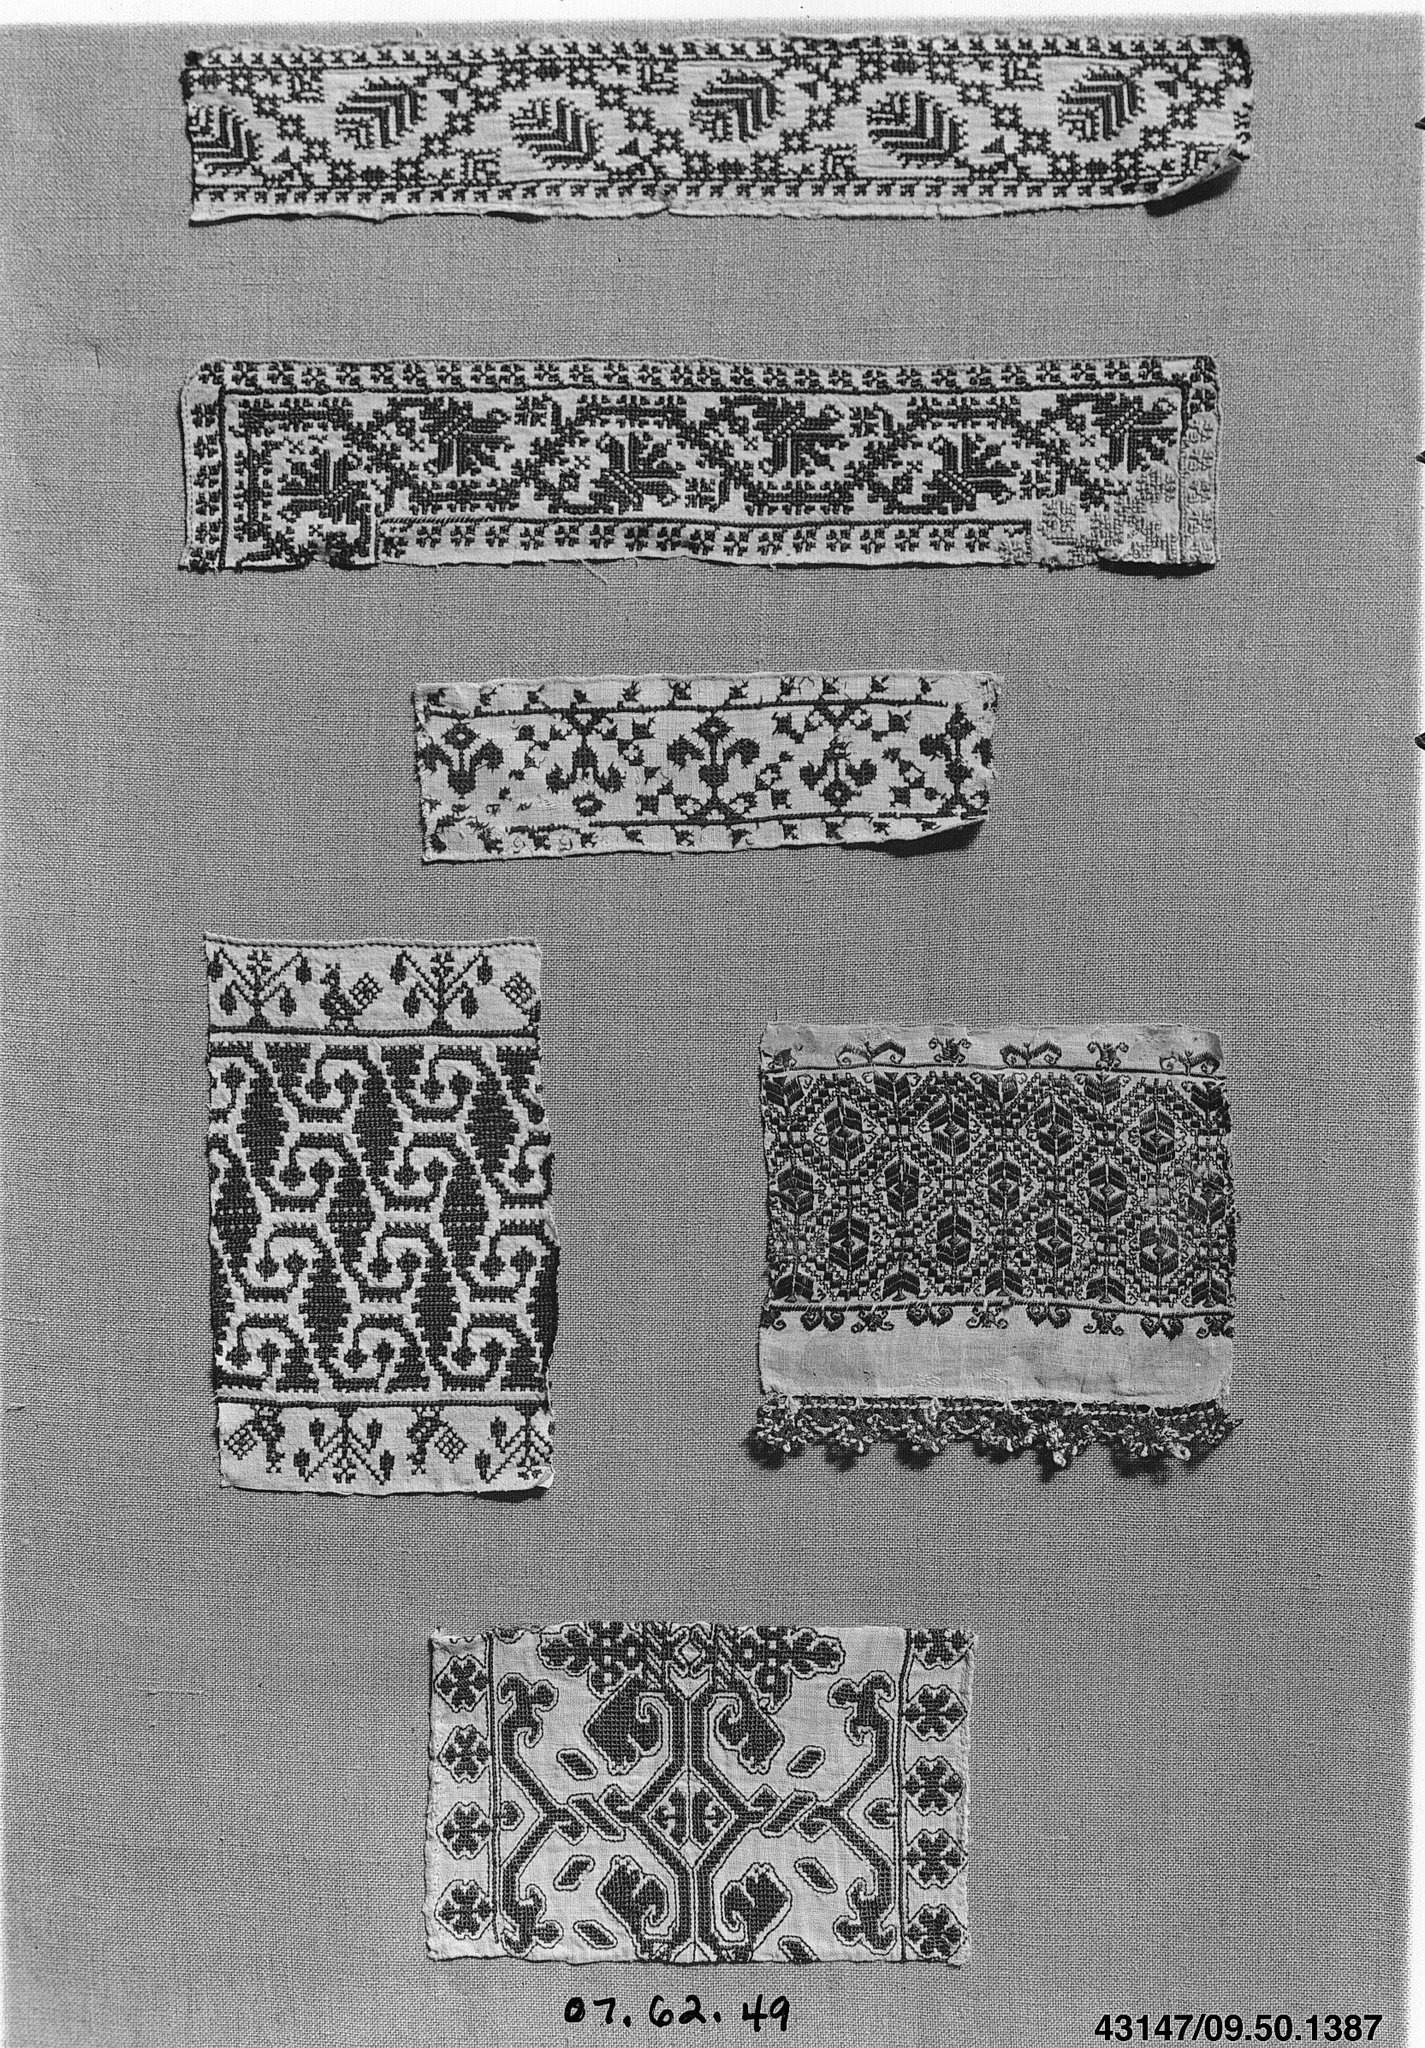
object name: fragment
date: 1701-1800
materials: linen, silk